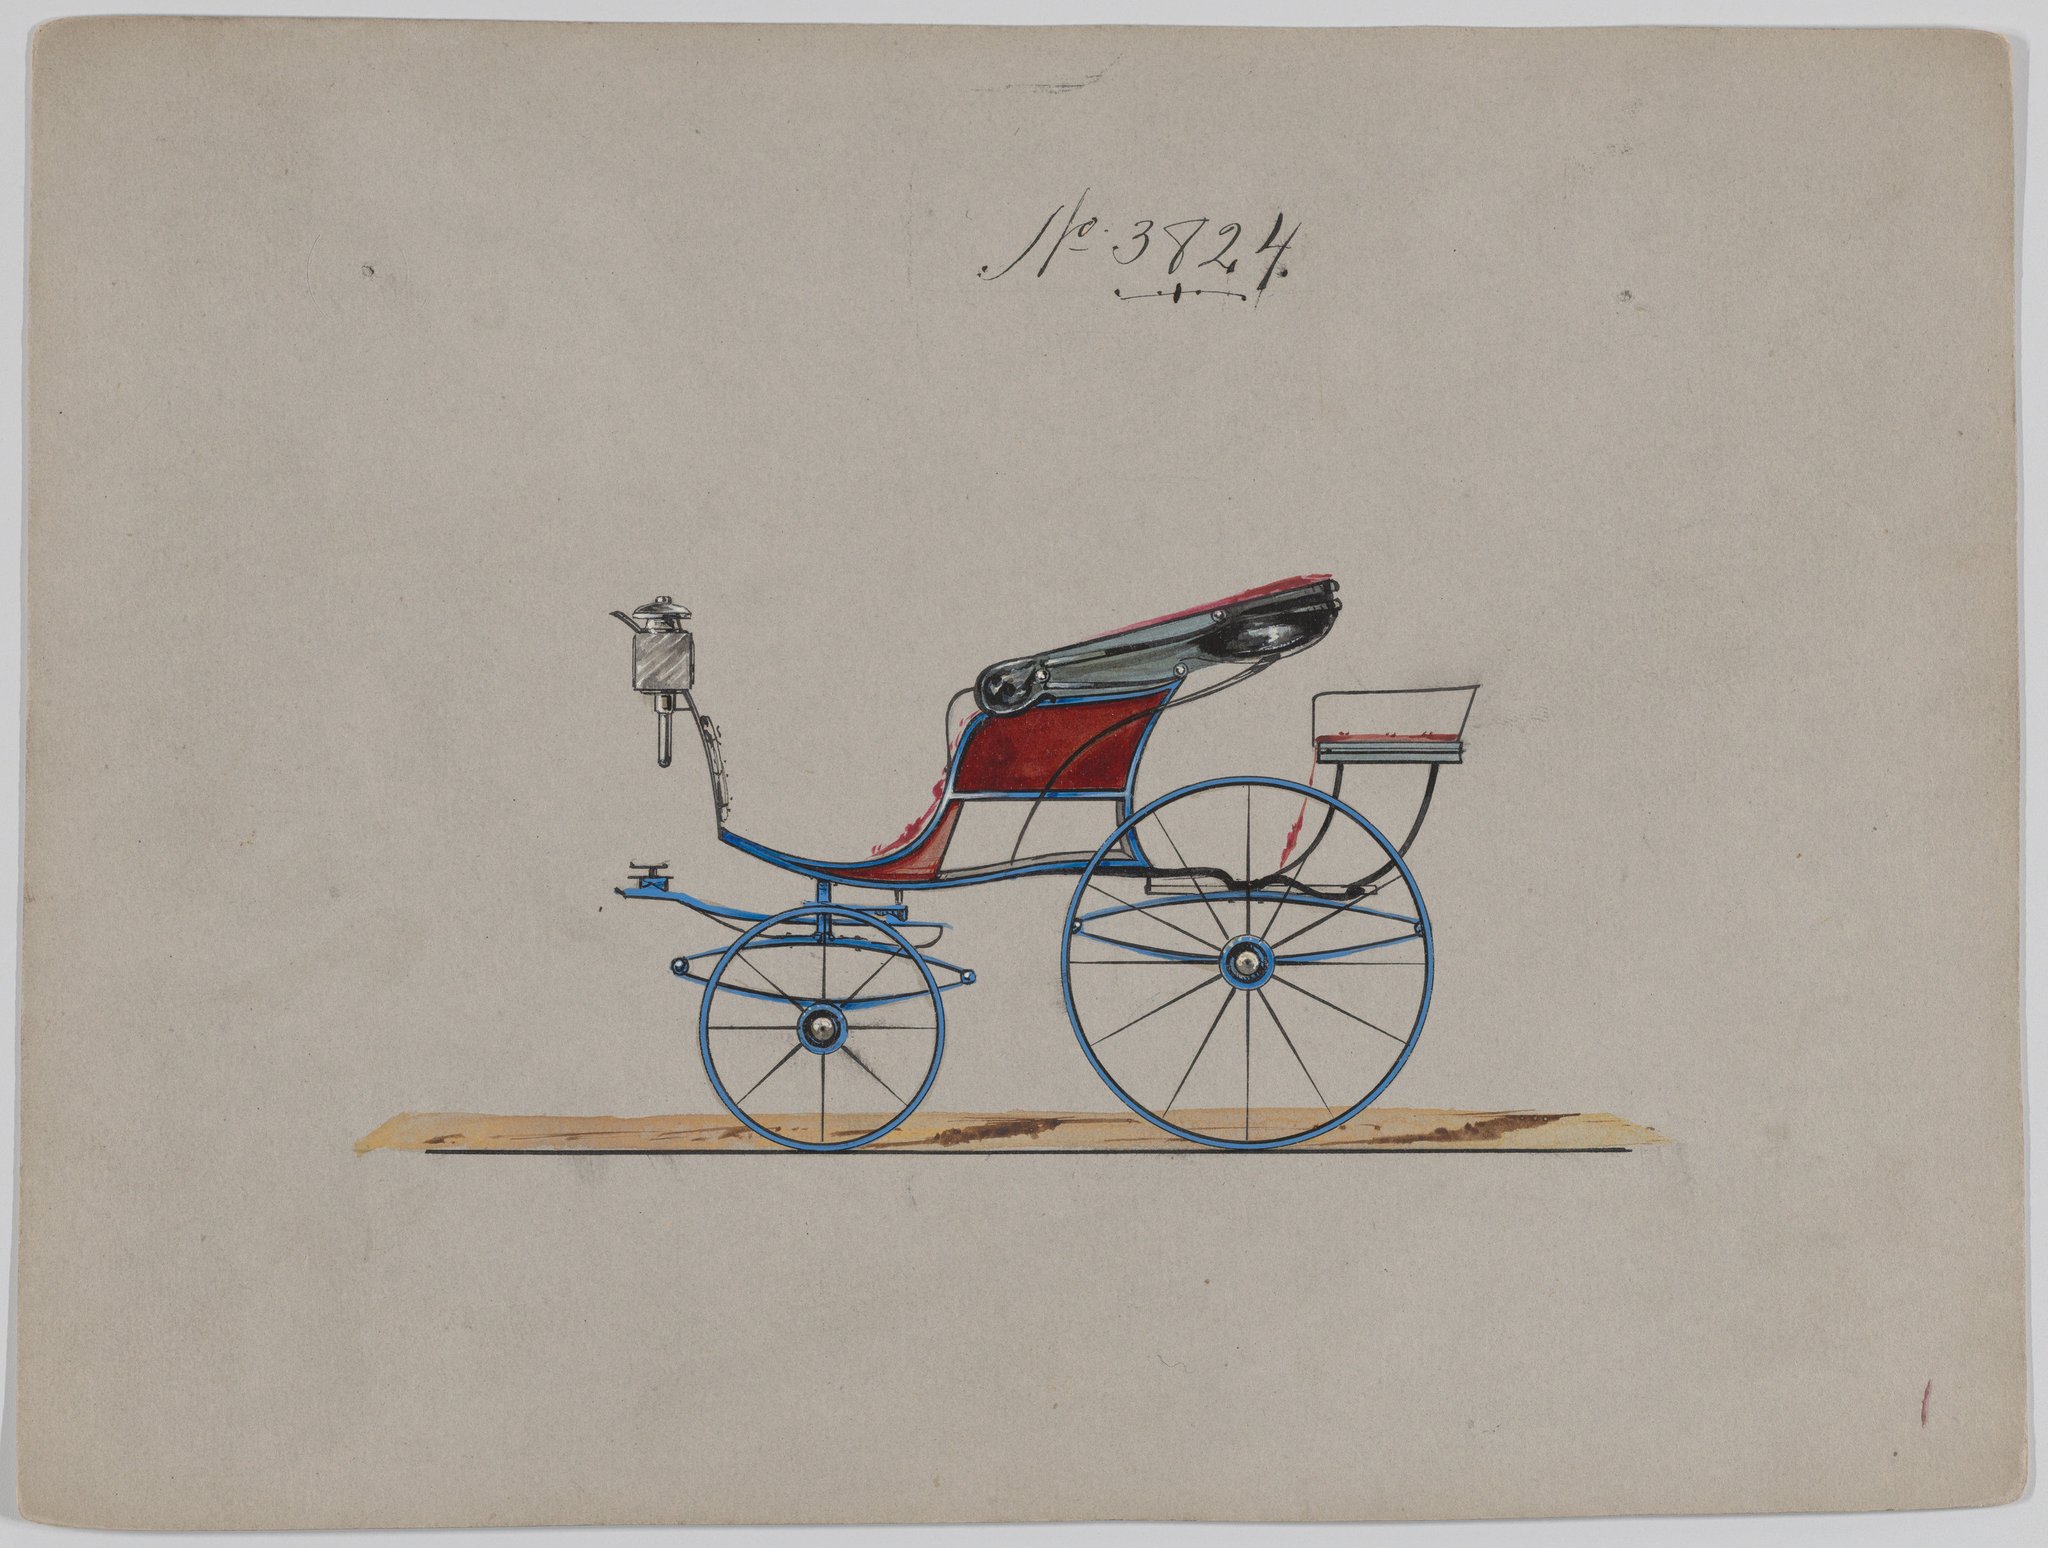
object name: drawing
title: Design for Pony Phaeton, no. 3824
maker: brewster & co.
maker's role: manufacturer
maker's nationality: american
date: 1883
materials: gouache, gum arabic, ink, watercolor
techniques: pen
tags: carriages